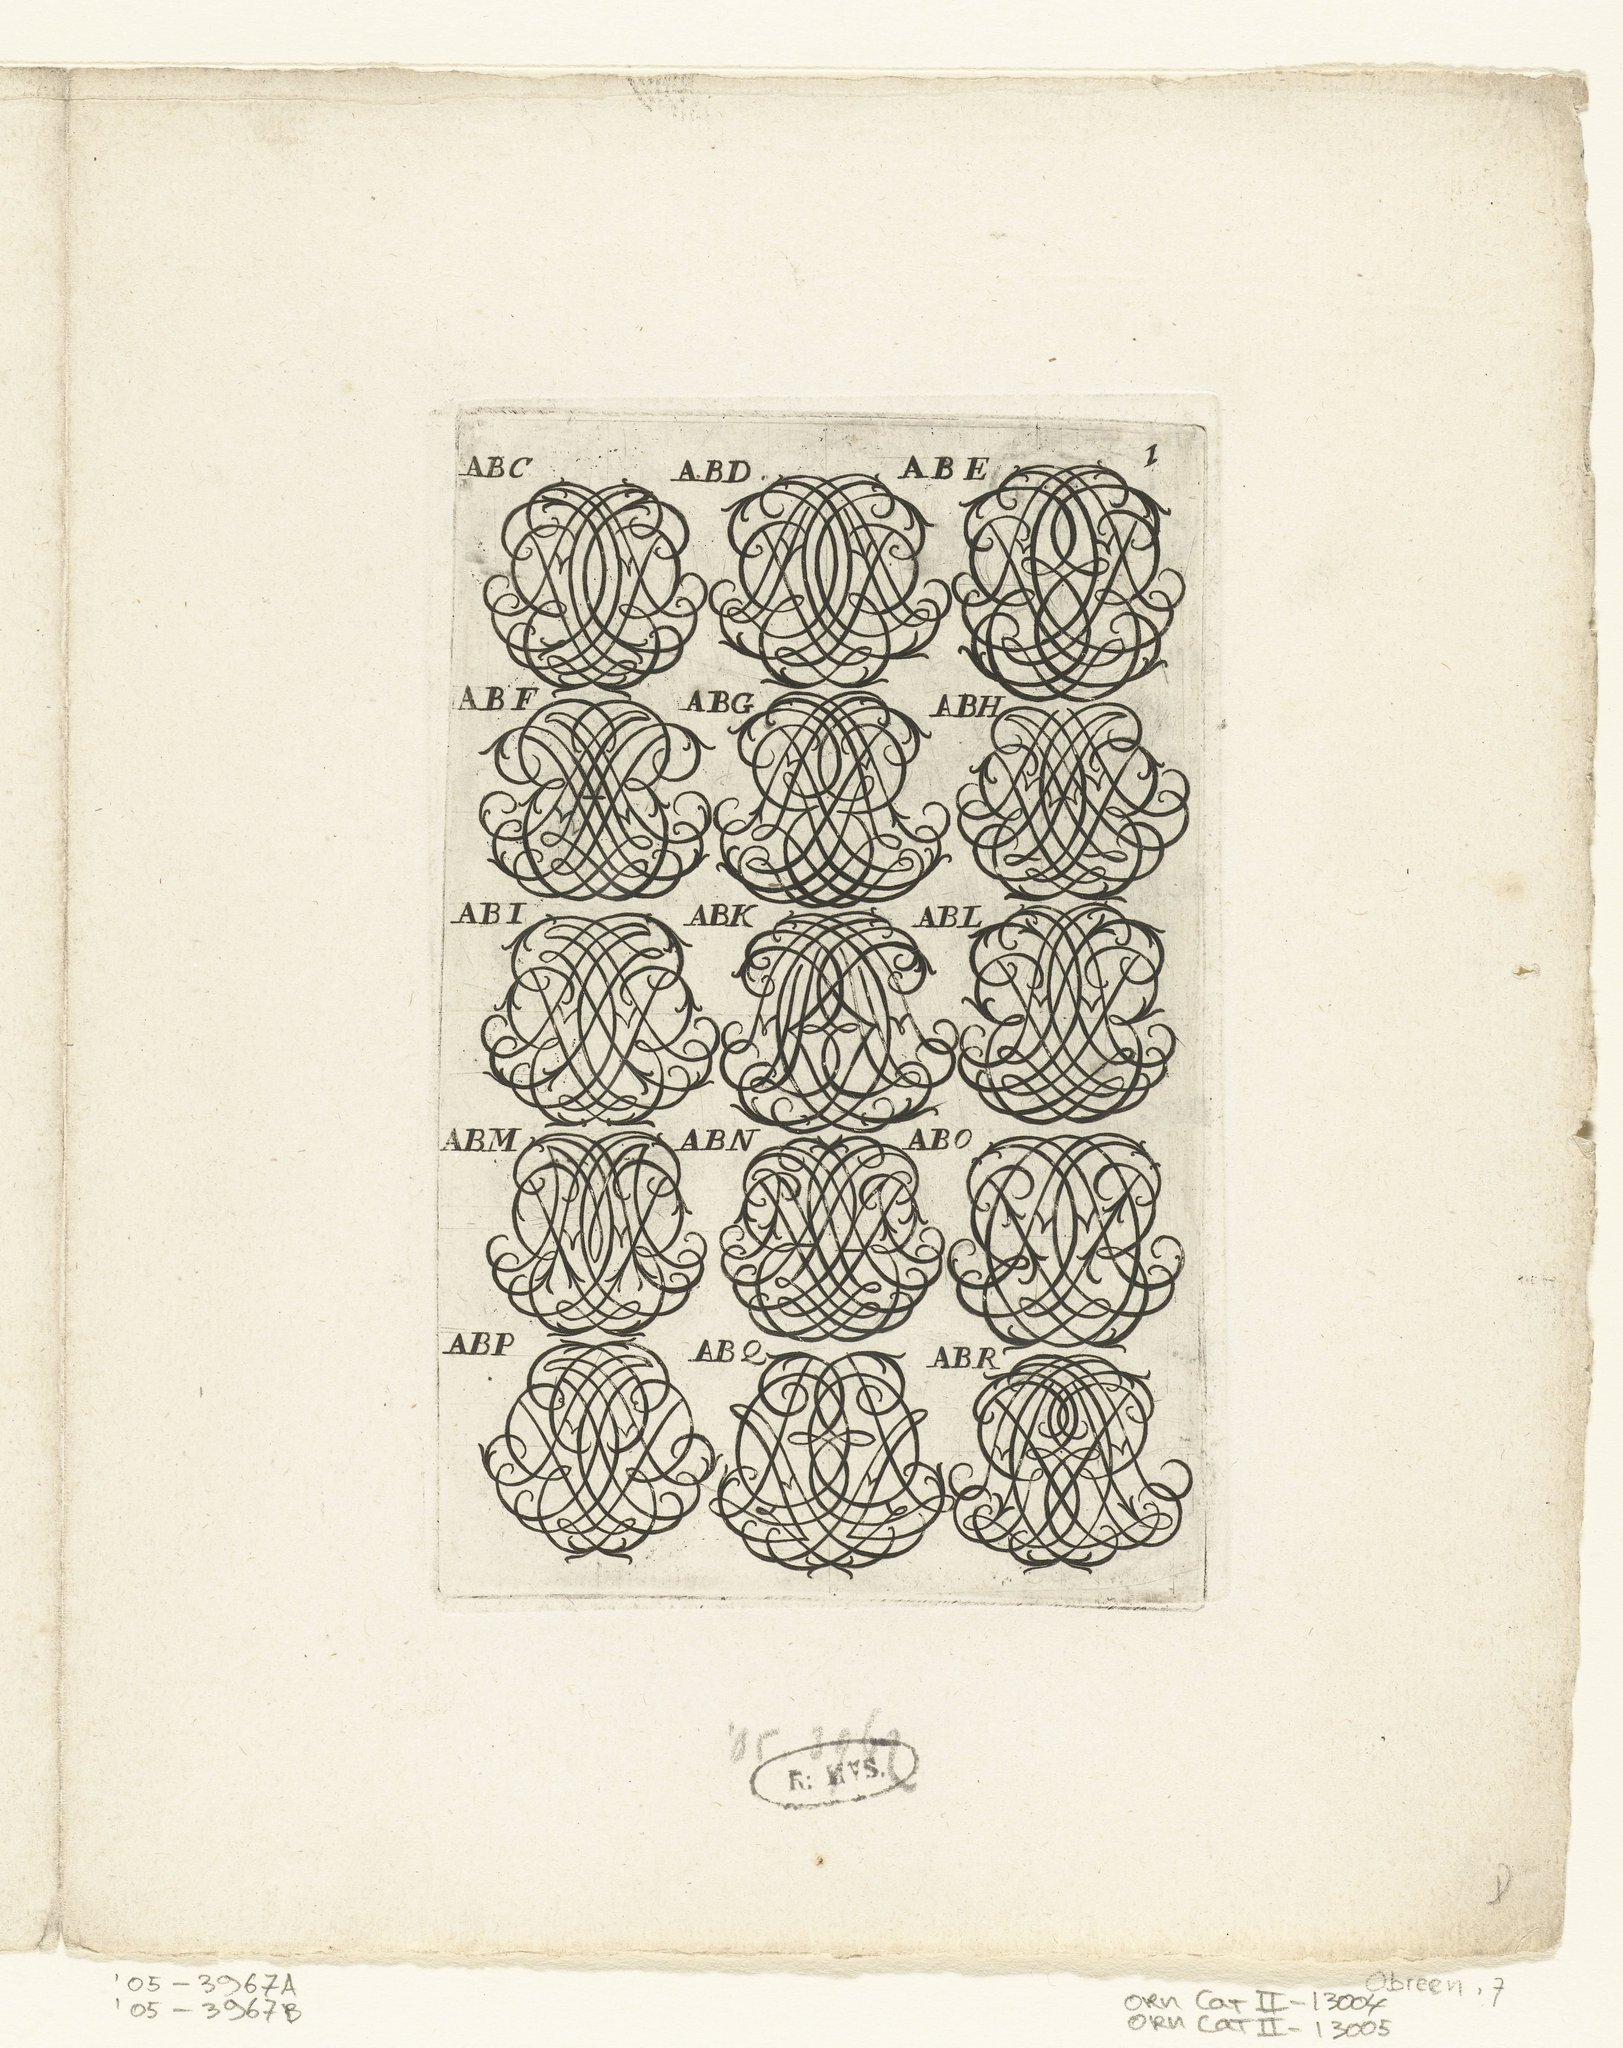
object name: ornament print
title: Livre nouveau et utile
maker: daniel de lafeuille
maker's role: print maker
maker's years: 1640-1709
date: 1690-1691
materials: paper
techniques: engraving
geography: amsterdam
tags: letters, alphabet, script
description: Uit serie van 29 deels genummerde bladen met cijfermonogrammen.